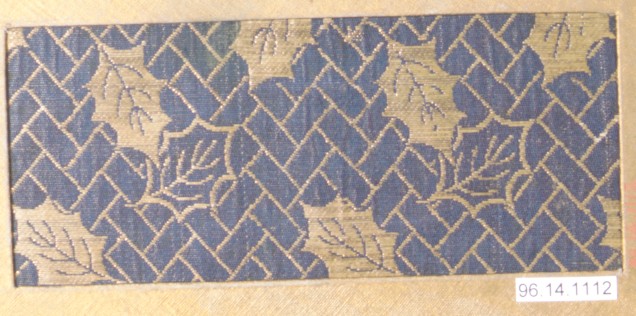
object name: piece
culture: japanese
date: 1701-1900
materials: silk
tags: leaves